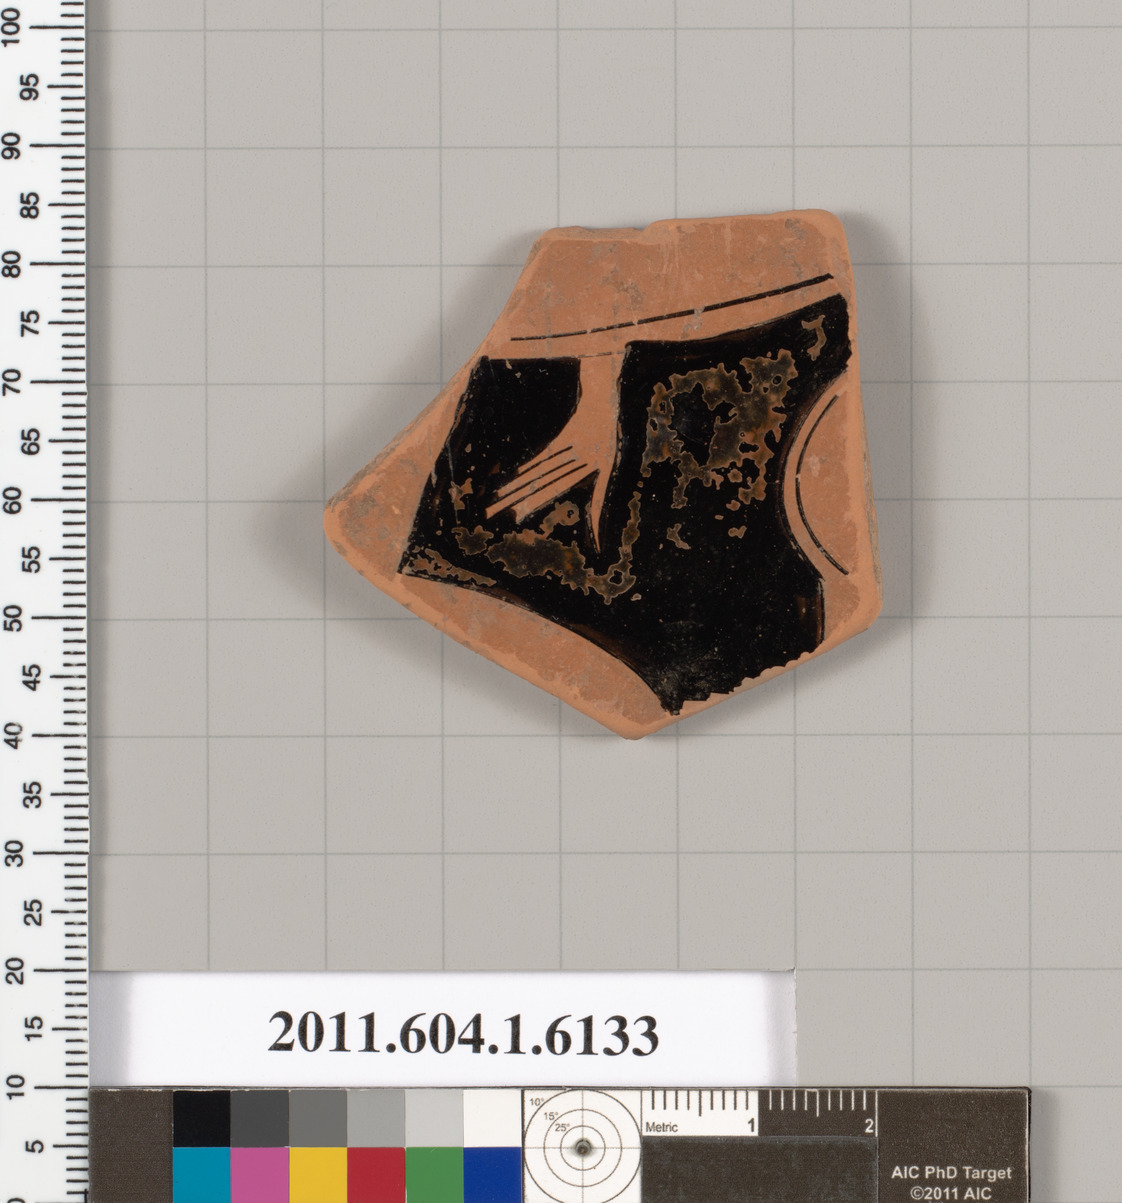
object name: kylix fragment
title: Terracotta fragment of a kylix (drinking cup)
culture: greek, attic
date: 520-500 BCE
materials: terracotta